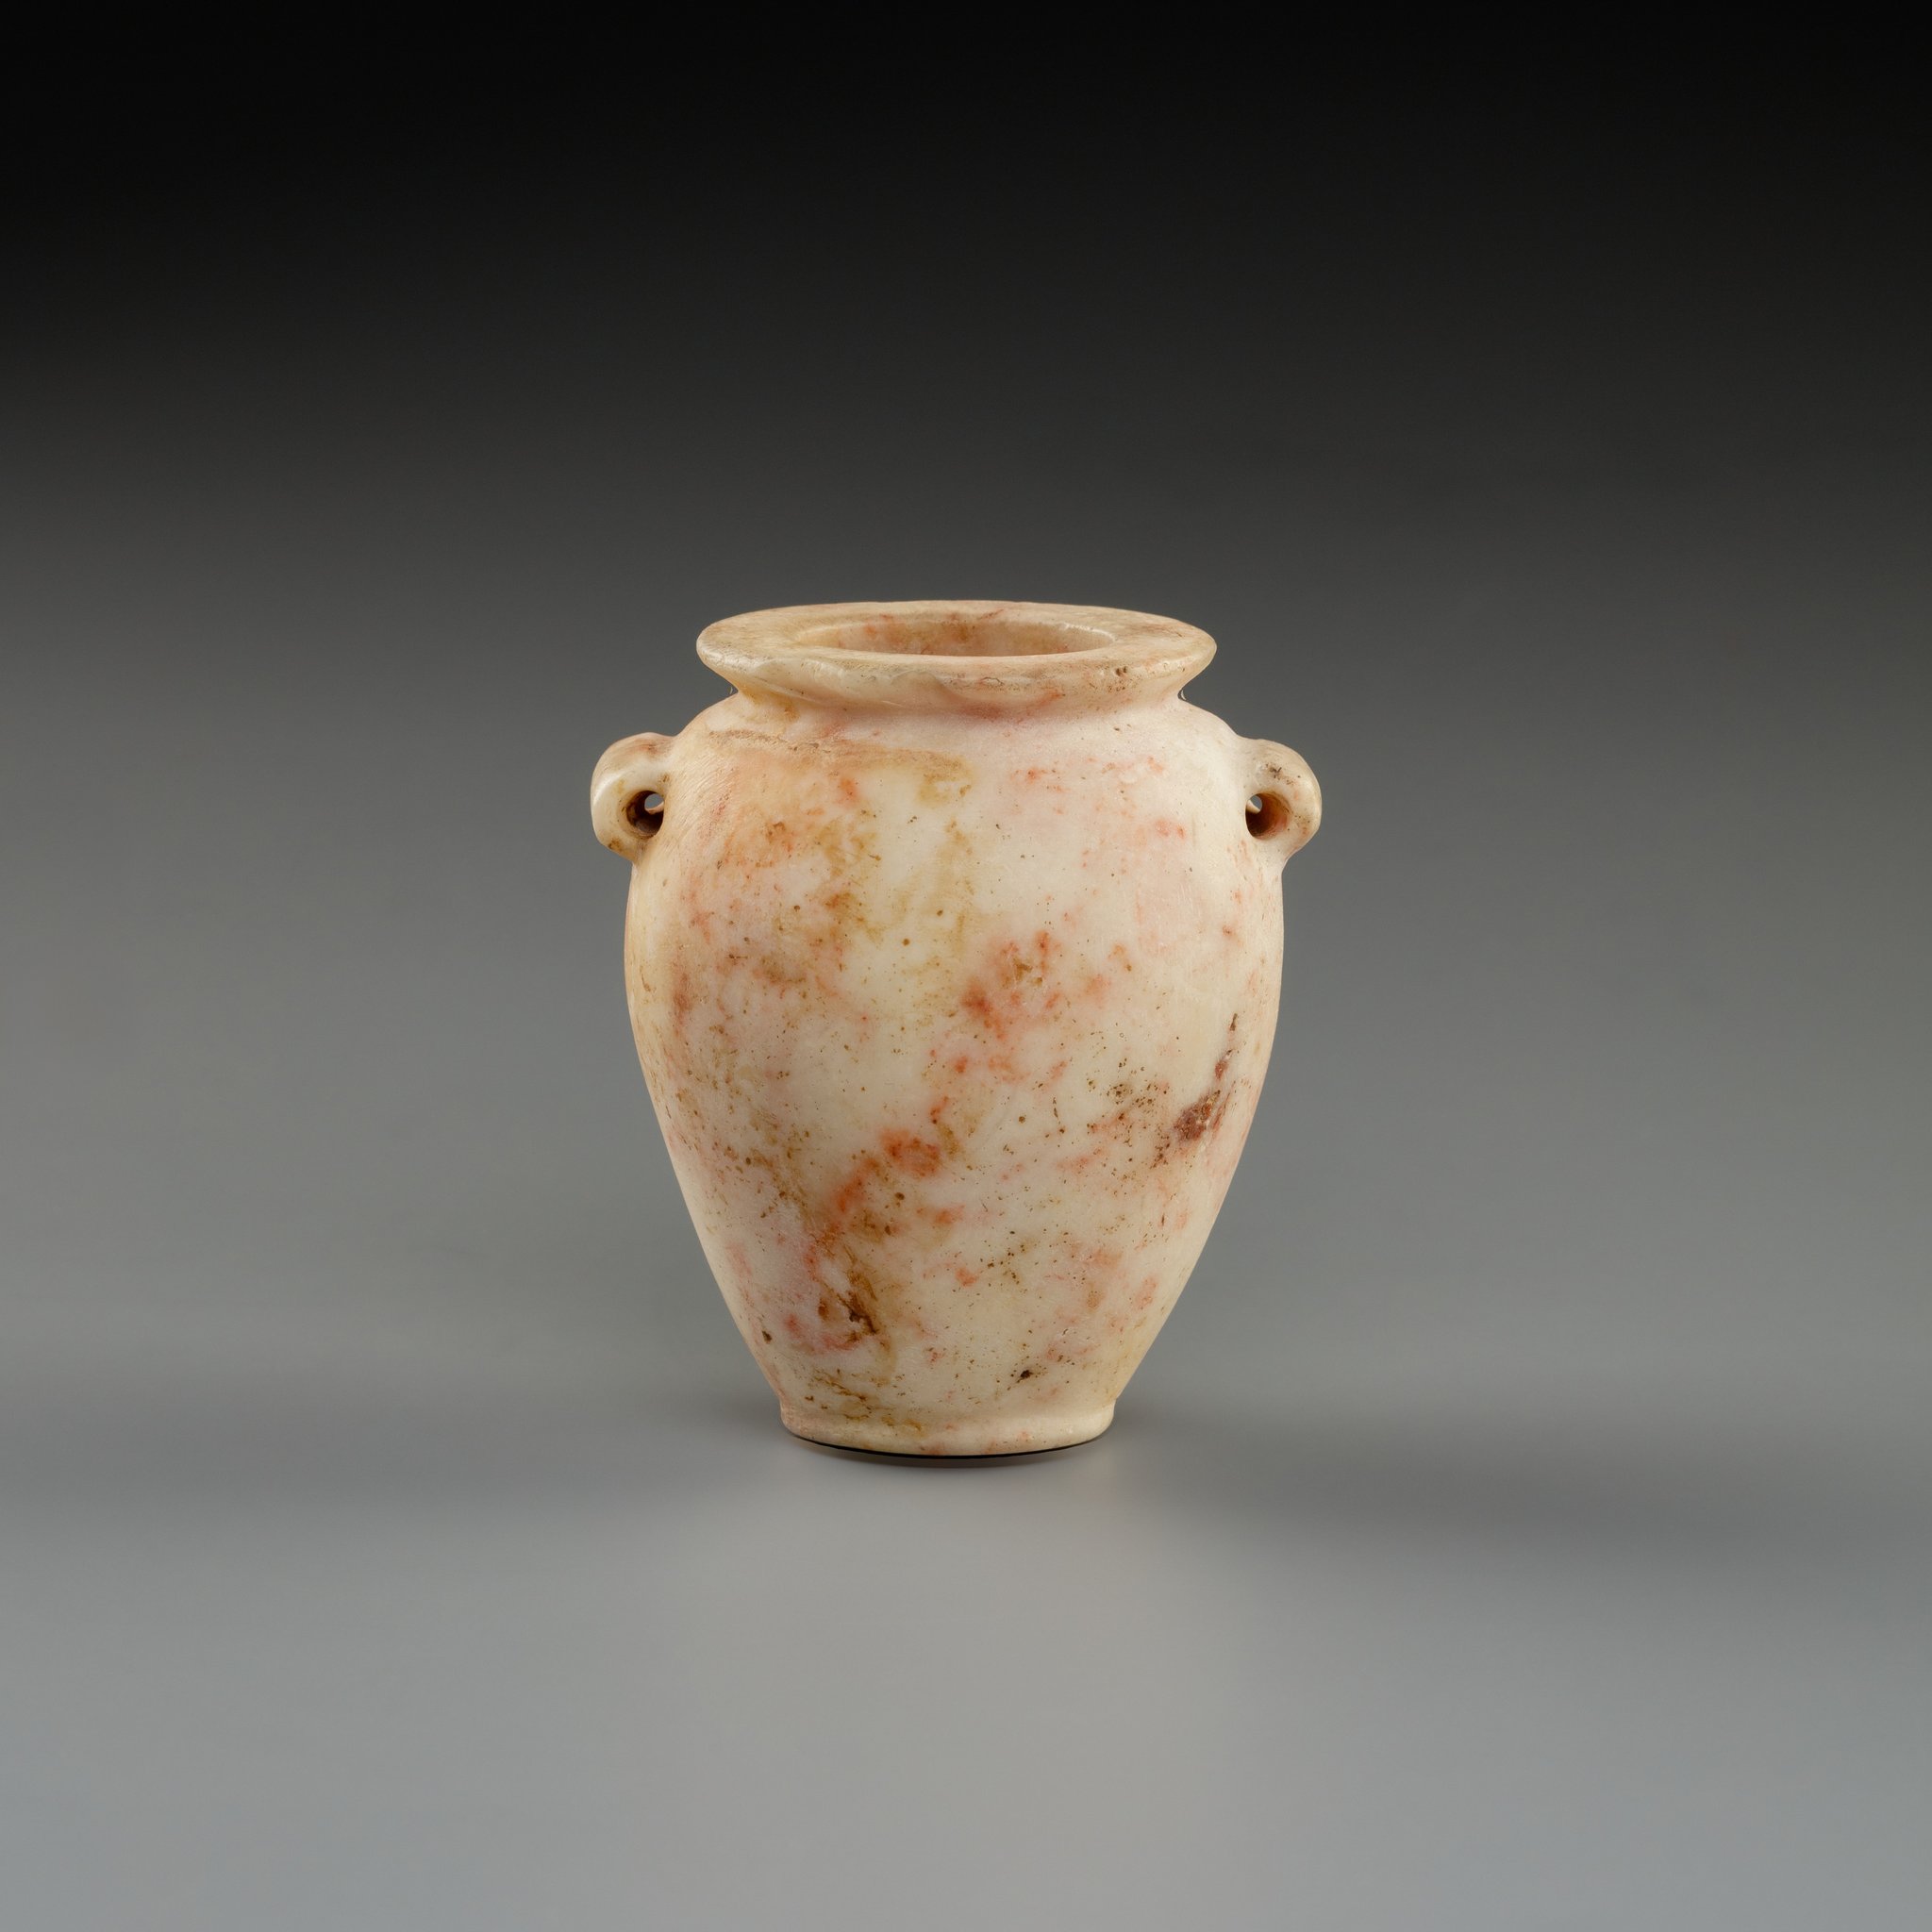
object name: jar, lug handle, squat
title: Jar, lug handles, squat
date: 3100-2650 BCE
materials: limestone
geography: egypt